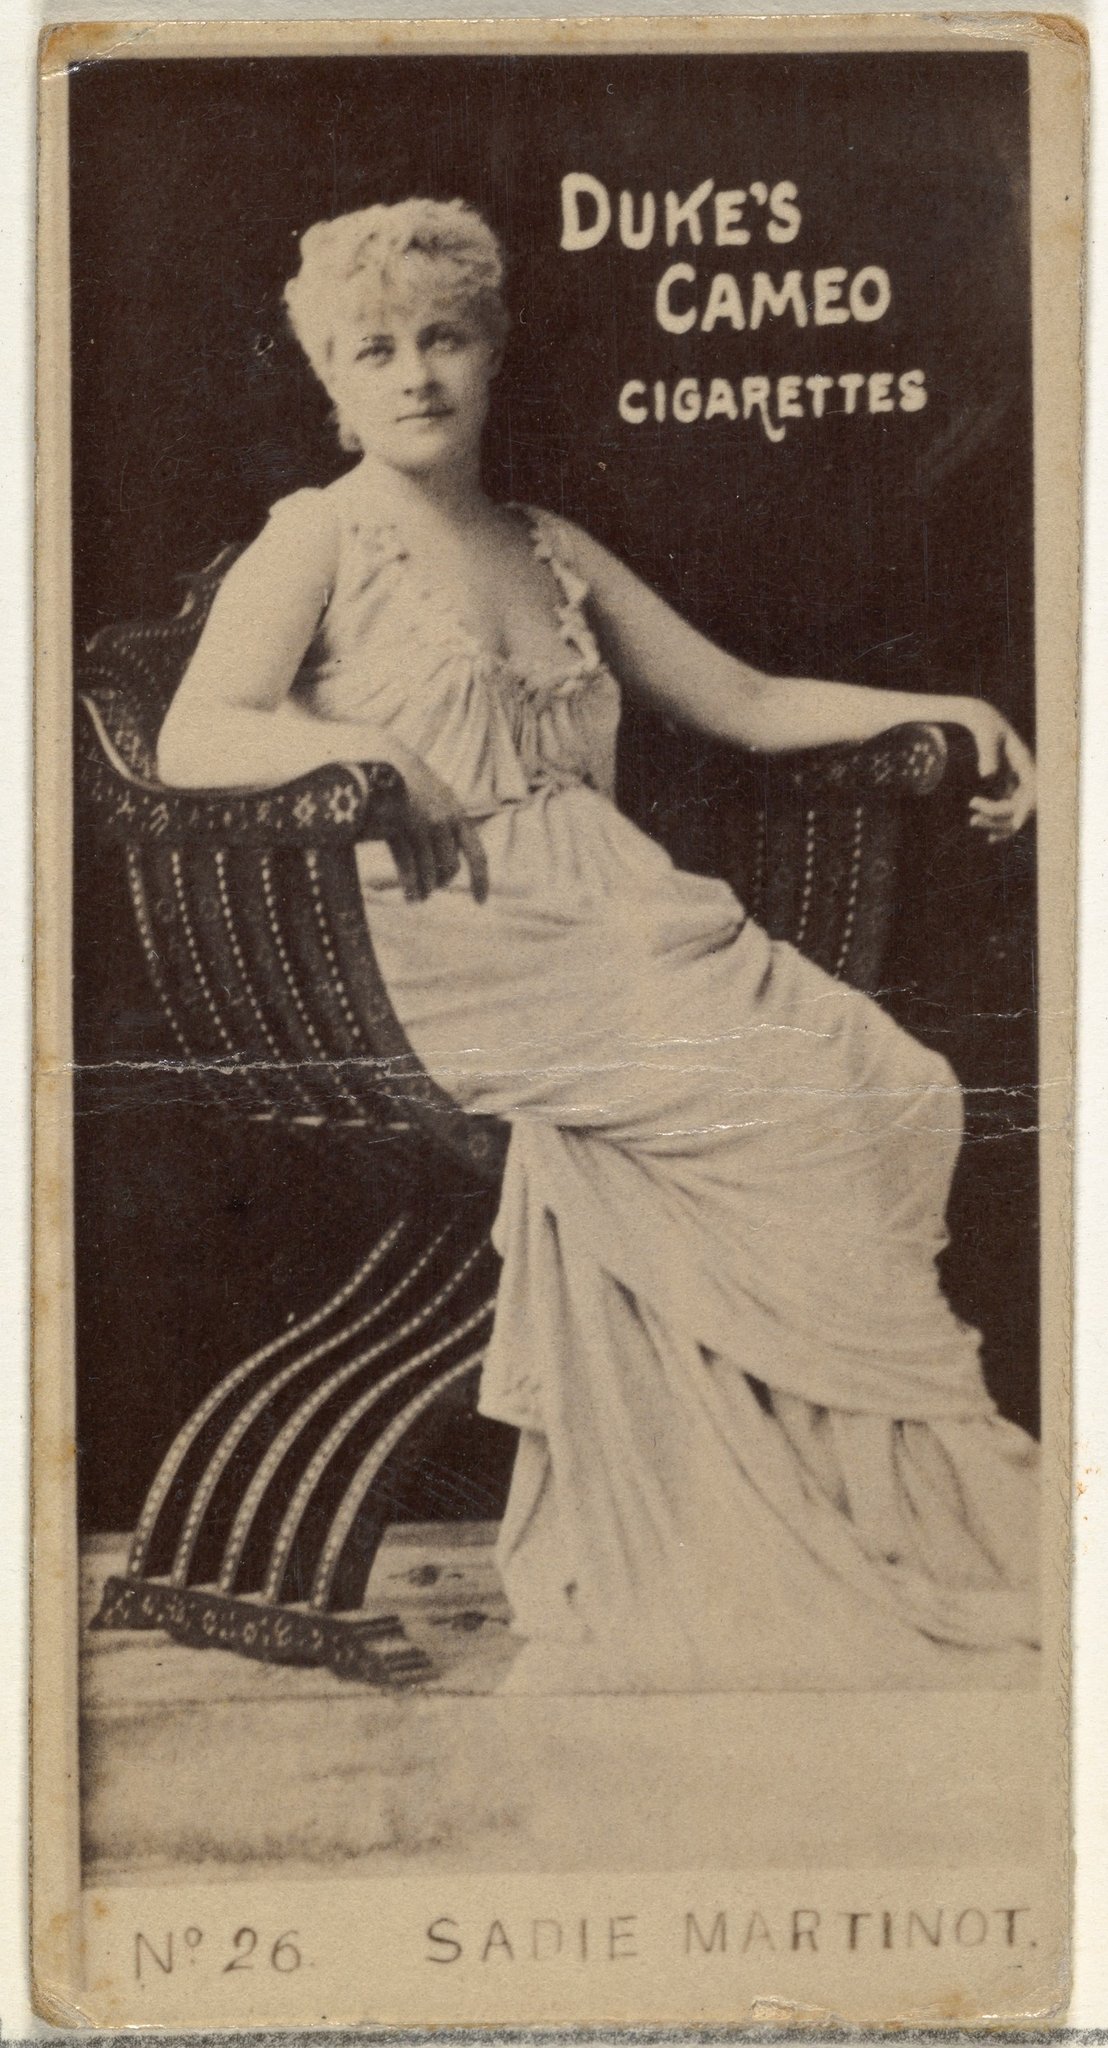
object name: photograph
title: Card Number 26, Sadie Martinot, from the Actors and Actresses series (N145-4) issued by Duke Sons & Co. to promote Cameo Cigarettes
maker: w. duke, sons & co.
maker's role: publisher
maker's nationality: american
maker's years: 1870-1920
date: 1880-1889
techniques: albumen silver print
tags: portraits,women,actresses